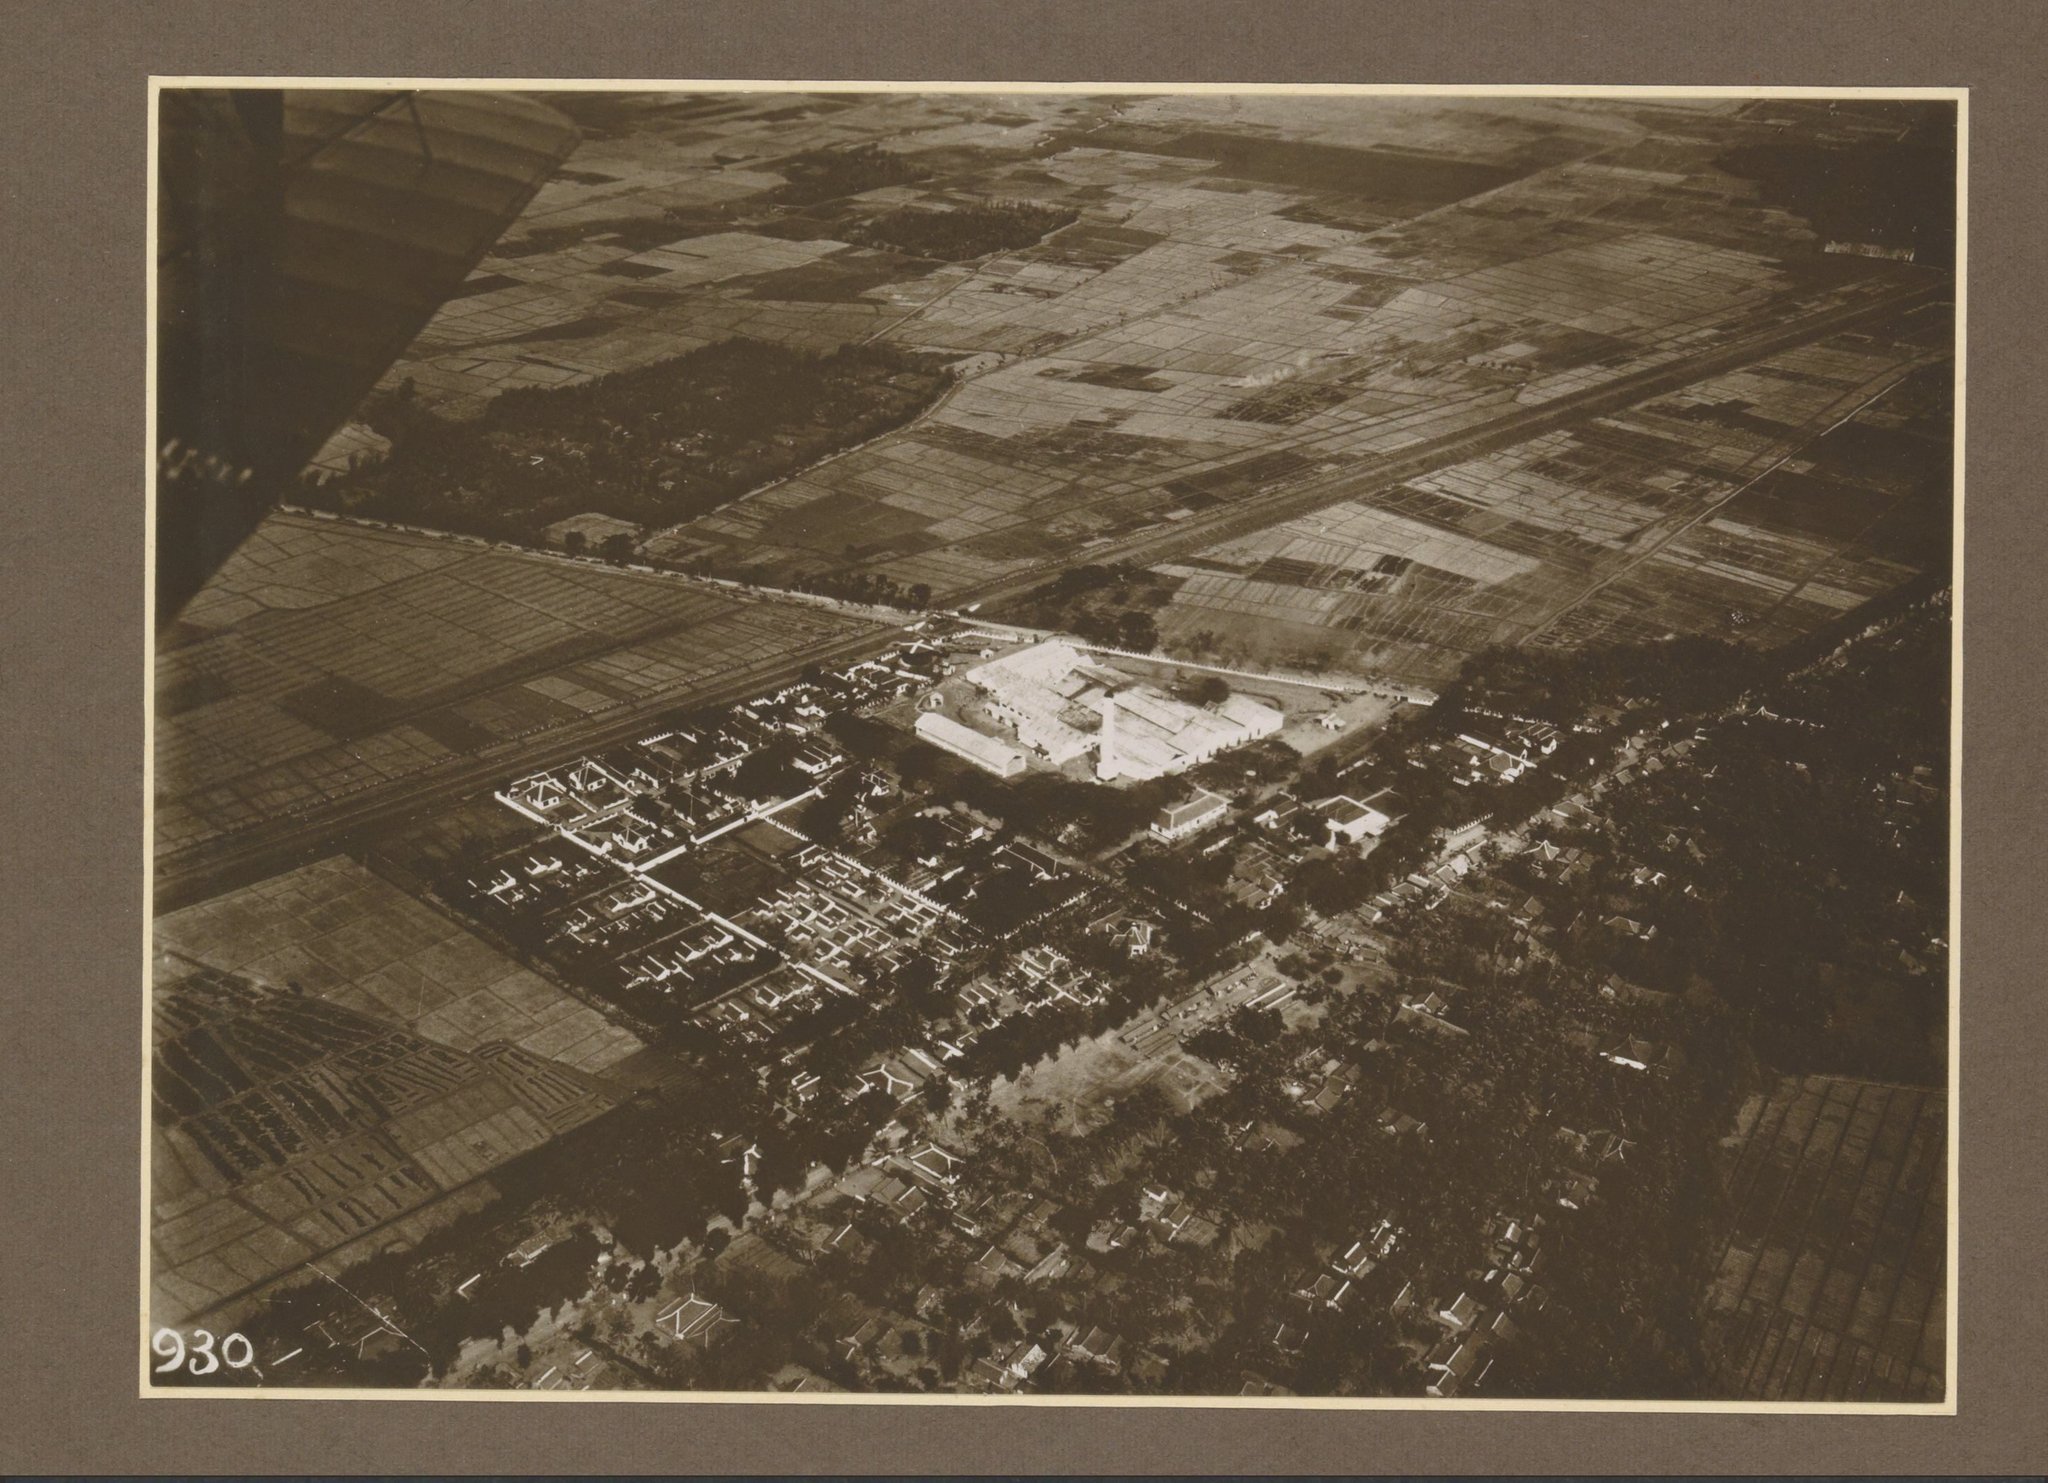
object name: album leaf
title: Hal met verdampingsinstallatie van suikerfabriek Ngandjoek op Java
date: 1925-1930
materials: cardboard, paper, photographic support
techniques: gelatin silver print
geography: nganjuk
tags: plantation, factory-interior, machine shop, plants and herbs: sugarcane, sugar, dutch east indies, the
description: Onderdeel van Fotoalbum met opnames van vier suikerfabrieken op Java.